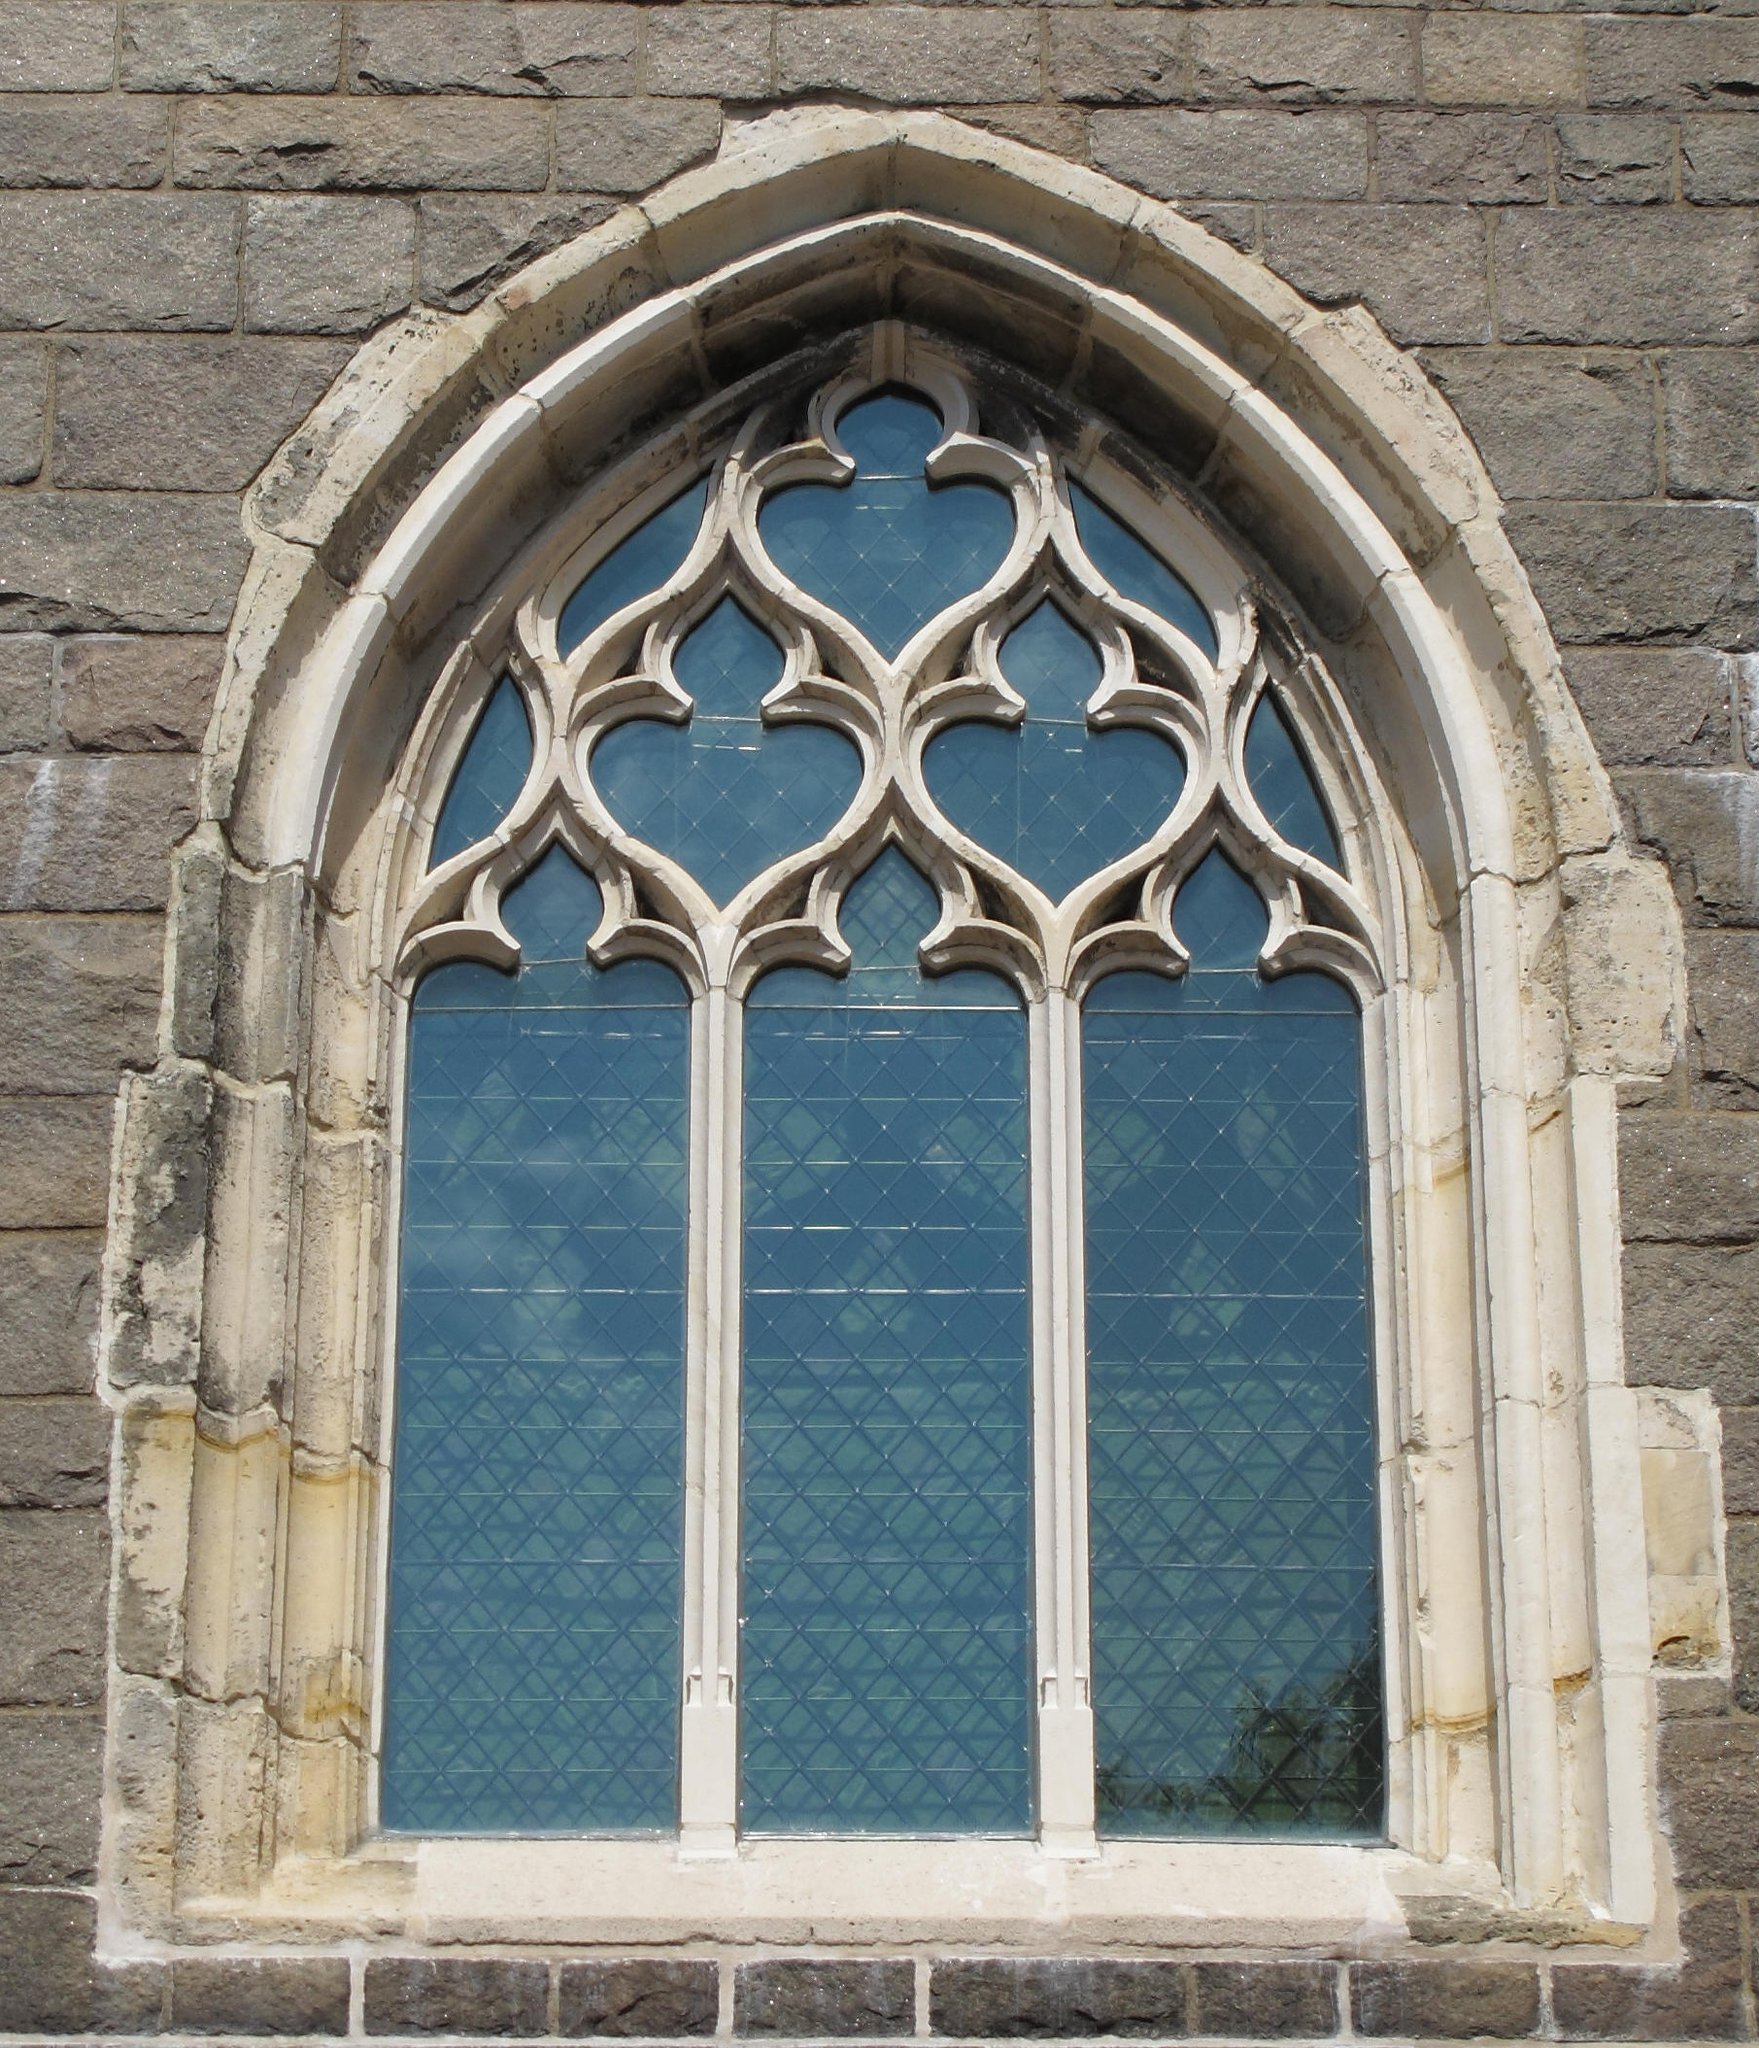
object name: window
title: Window with Flamboyant Tracery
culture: french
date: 1401-1500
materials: limestone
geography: france